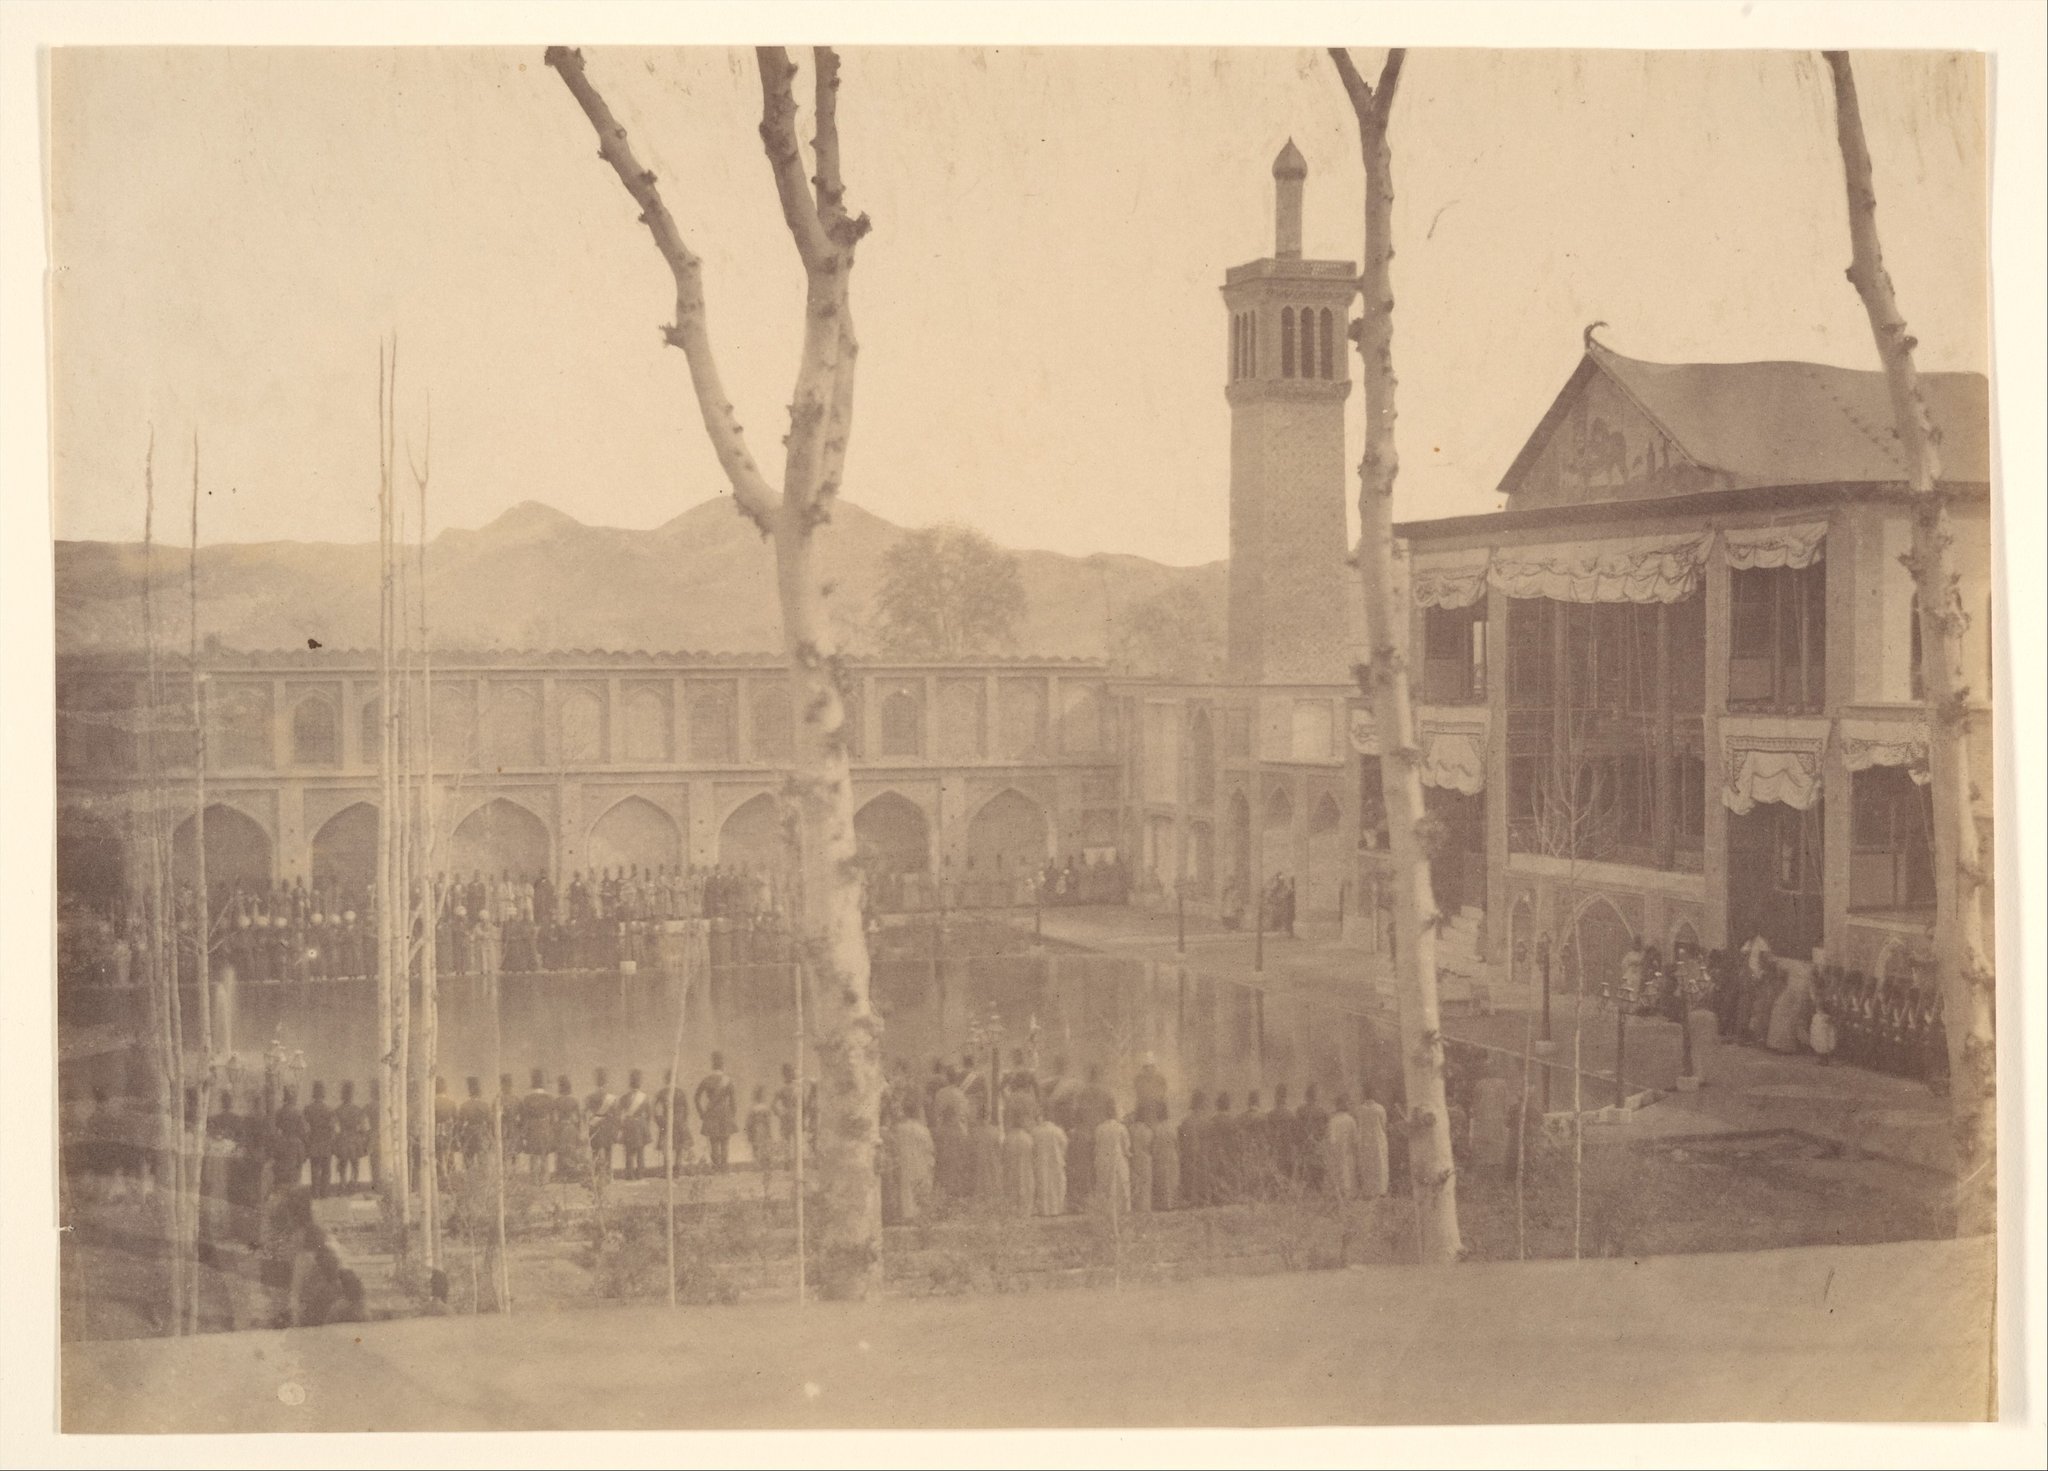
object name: photograph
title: [Palace of the Shah, Paying respects to the Shah/Fete de Salam, Teheran, Iran [same as 12] ]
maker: luigi pesce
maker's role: artist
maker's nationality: italian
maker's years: 1818-1891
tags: architecture,palaces